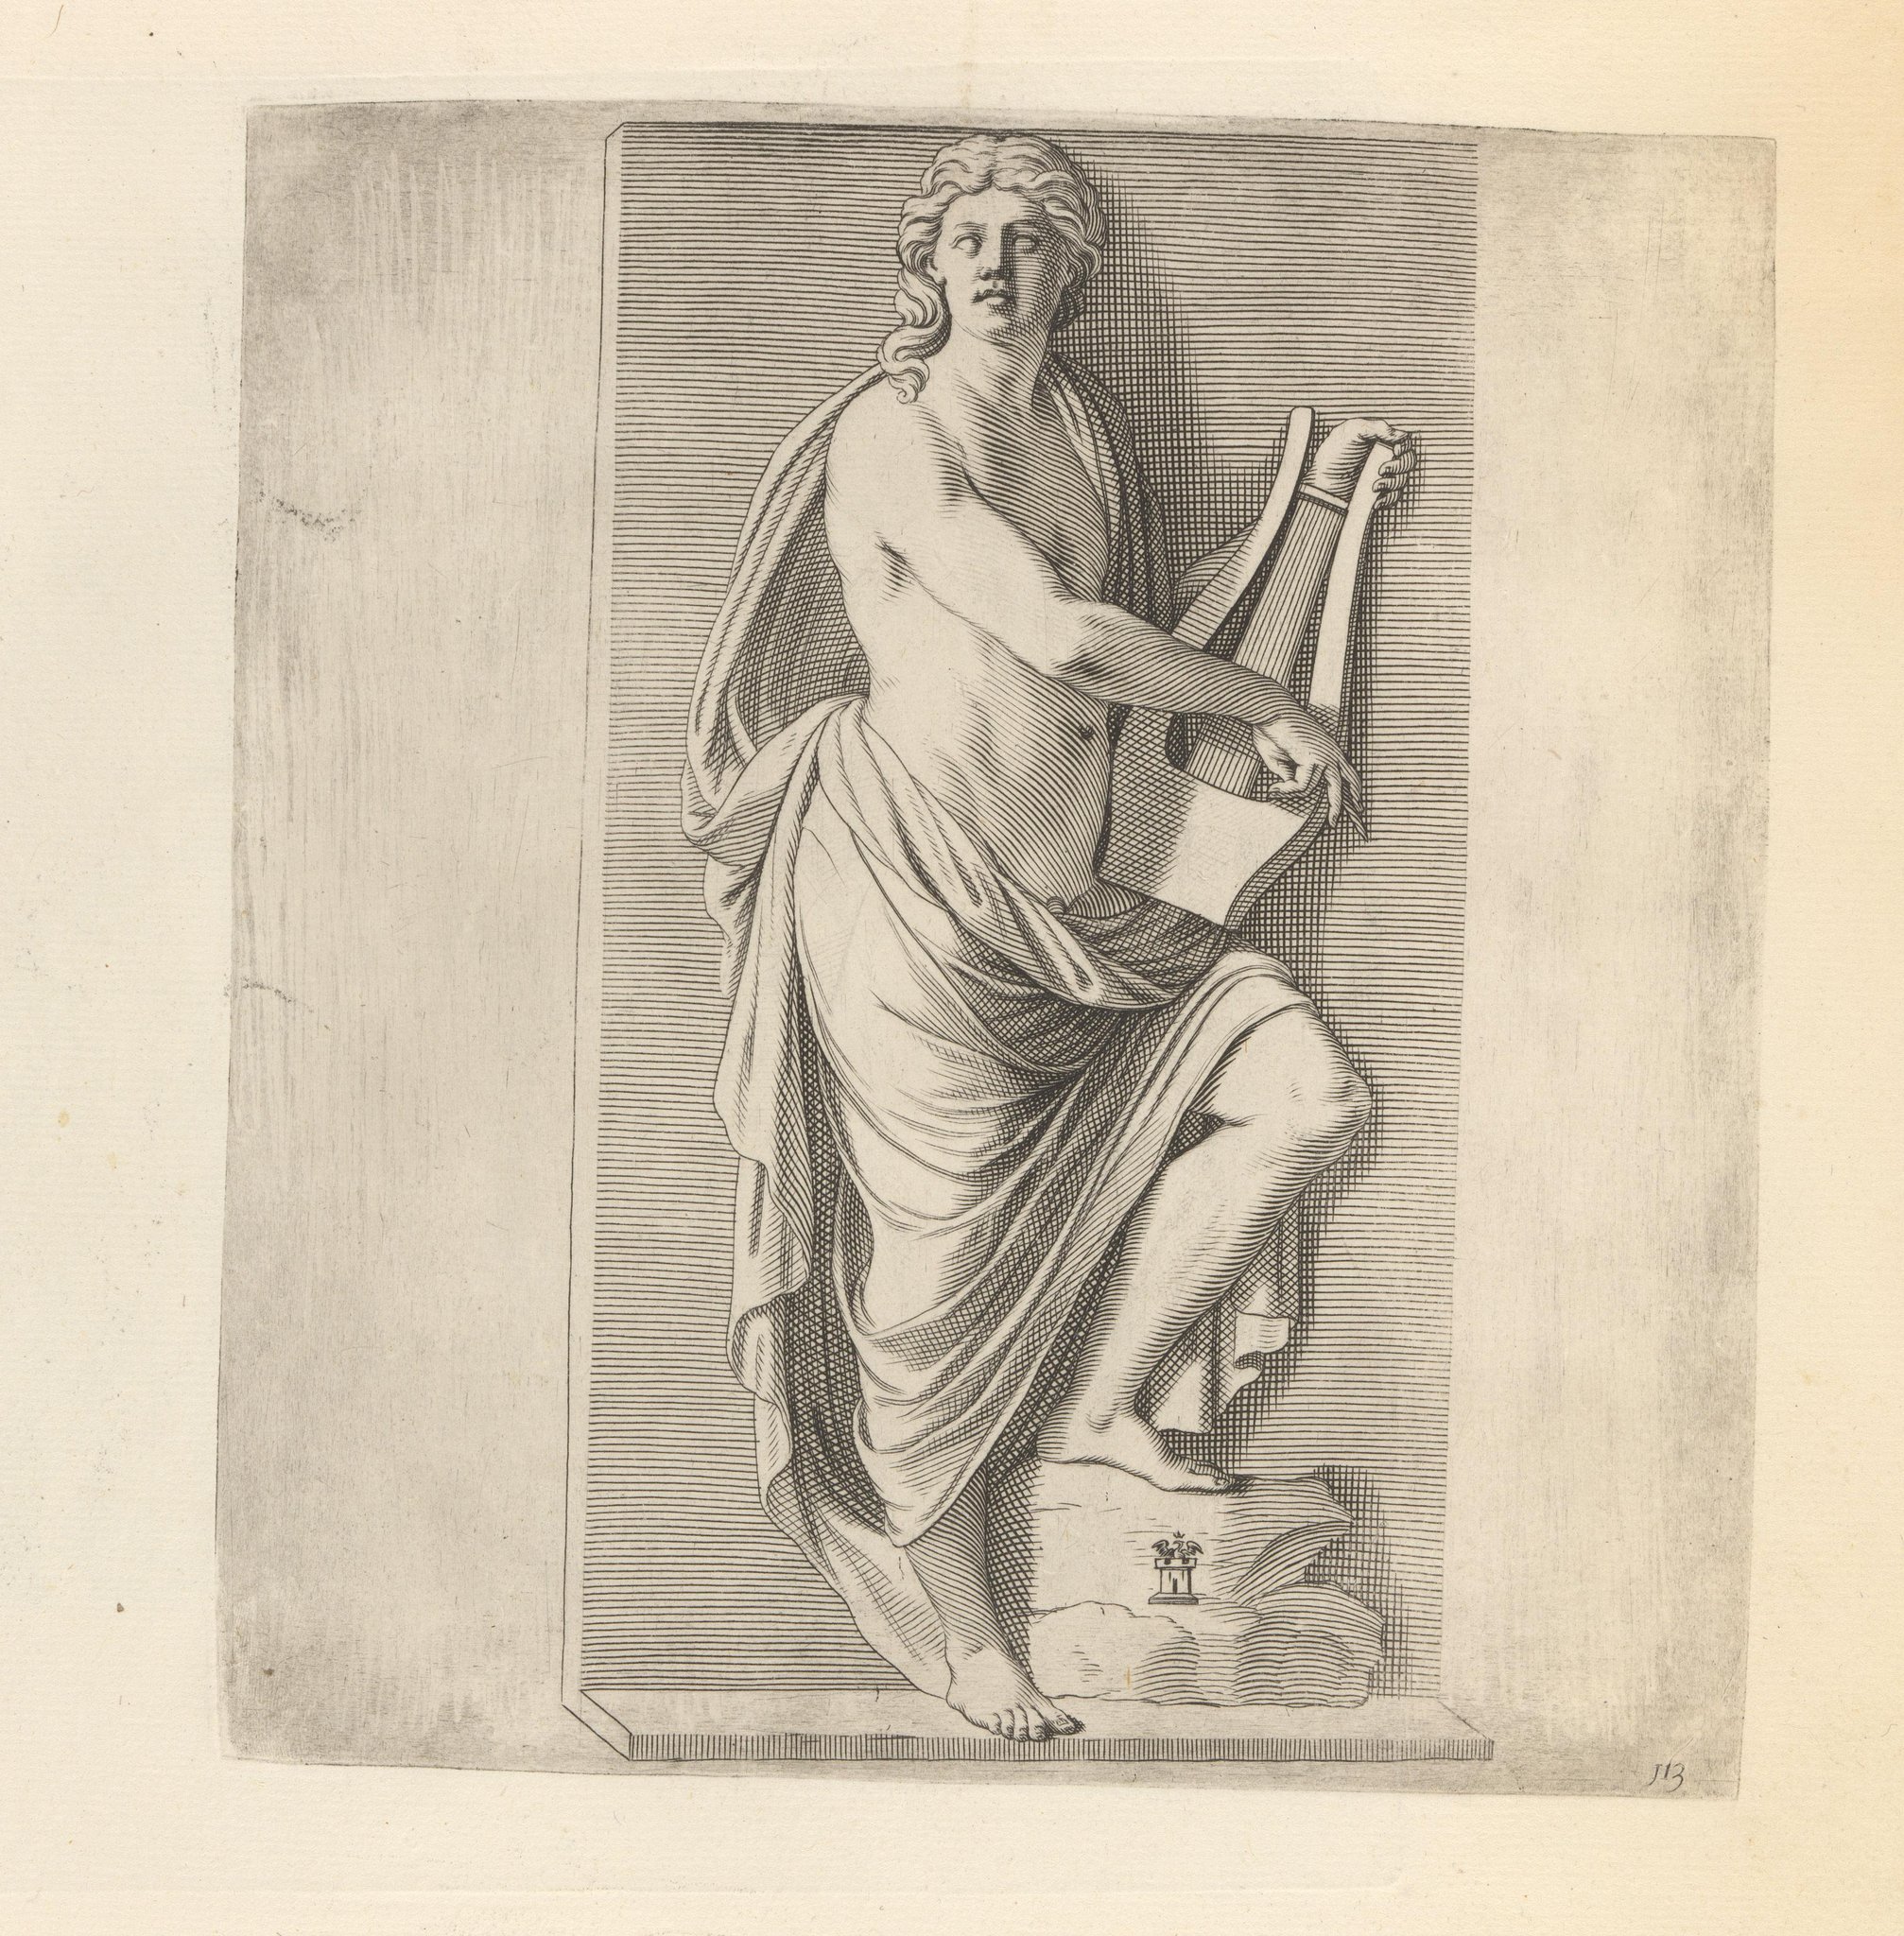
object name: album leaf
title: Bas-reliëf van Apollo met de lier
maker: michel natalis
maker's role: print maker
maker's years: 1610-1668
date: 1636-1647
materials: paper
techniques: engraving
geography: rome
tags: piece of sculpture, reproduction of a piece of sculpture, apollo playing the lyre, apollo citharoedus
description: Bas-reliëf van Apollo met de lier. Onderaan het wapenschild van Vincenzo Giustiniani. Prent maakt deel uit van een album met een serie prenten naar de sculpturen in de verzameling in de Galleria Giustiniani te Rome.